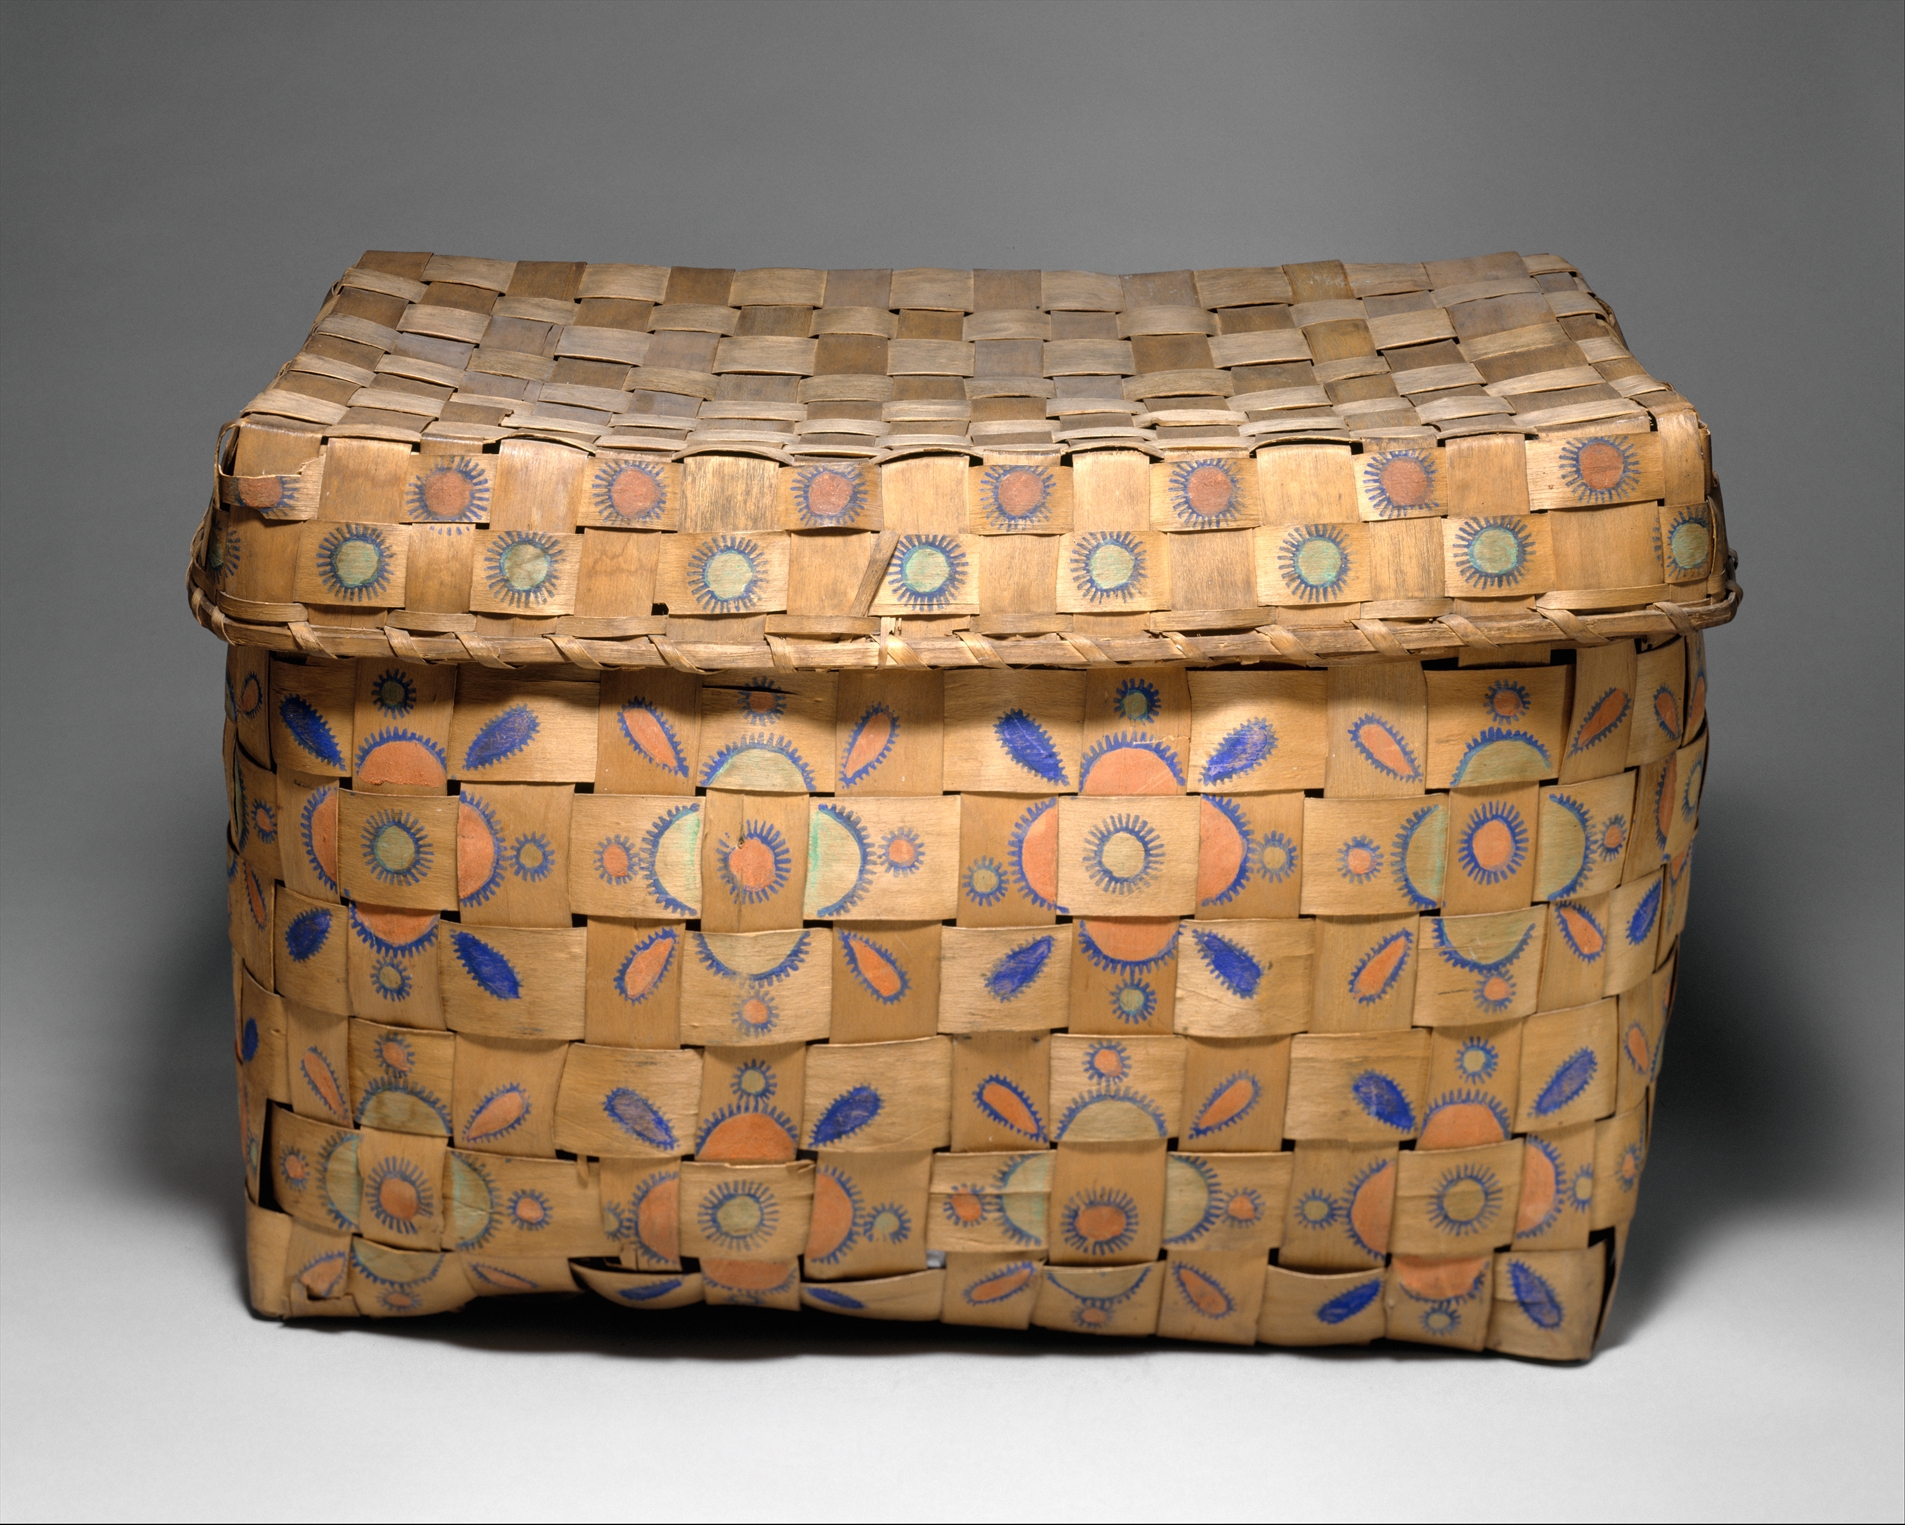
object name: basket with lid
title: Lidded Basket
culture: oneida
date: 1860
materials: wood, pigment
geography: united states